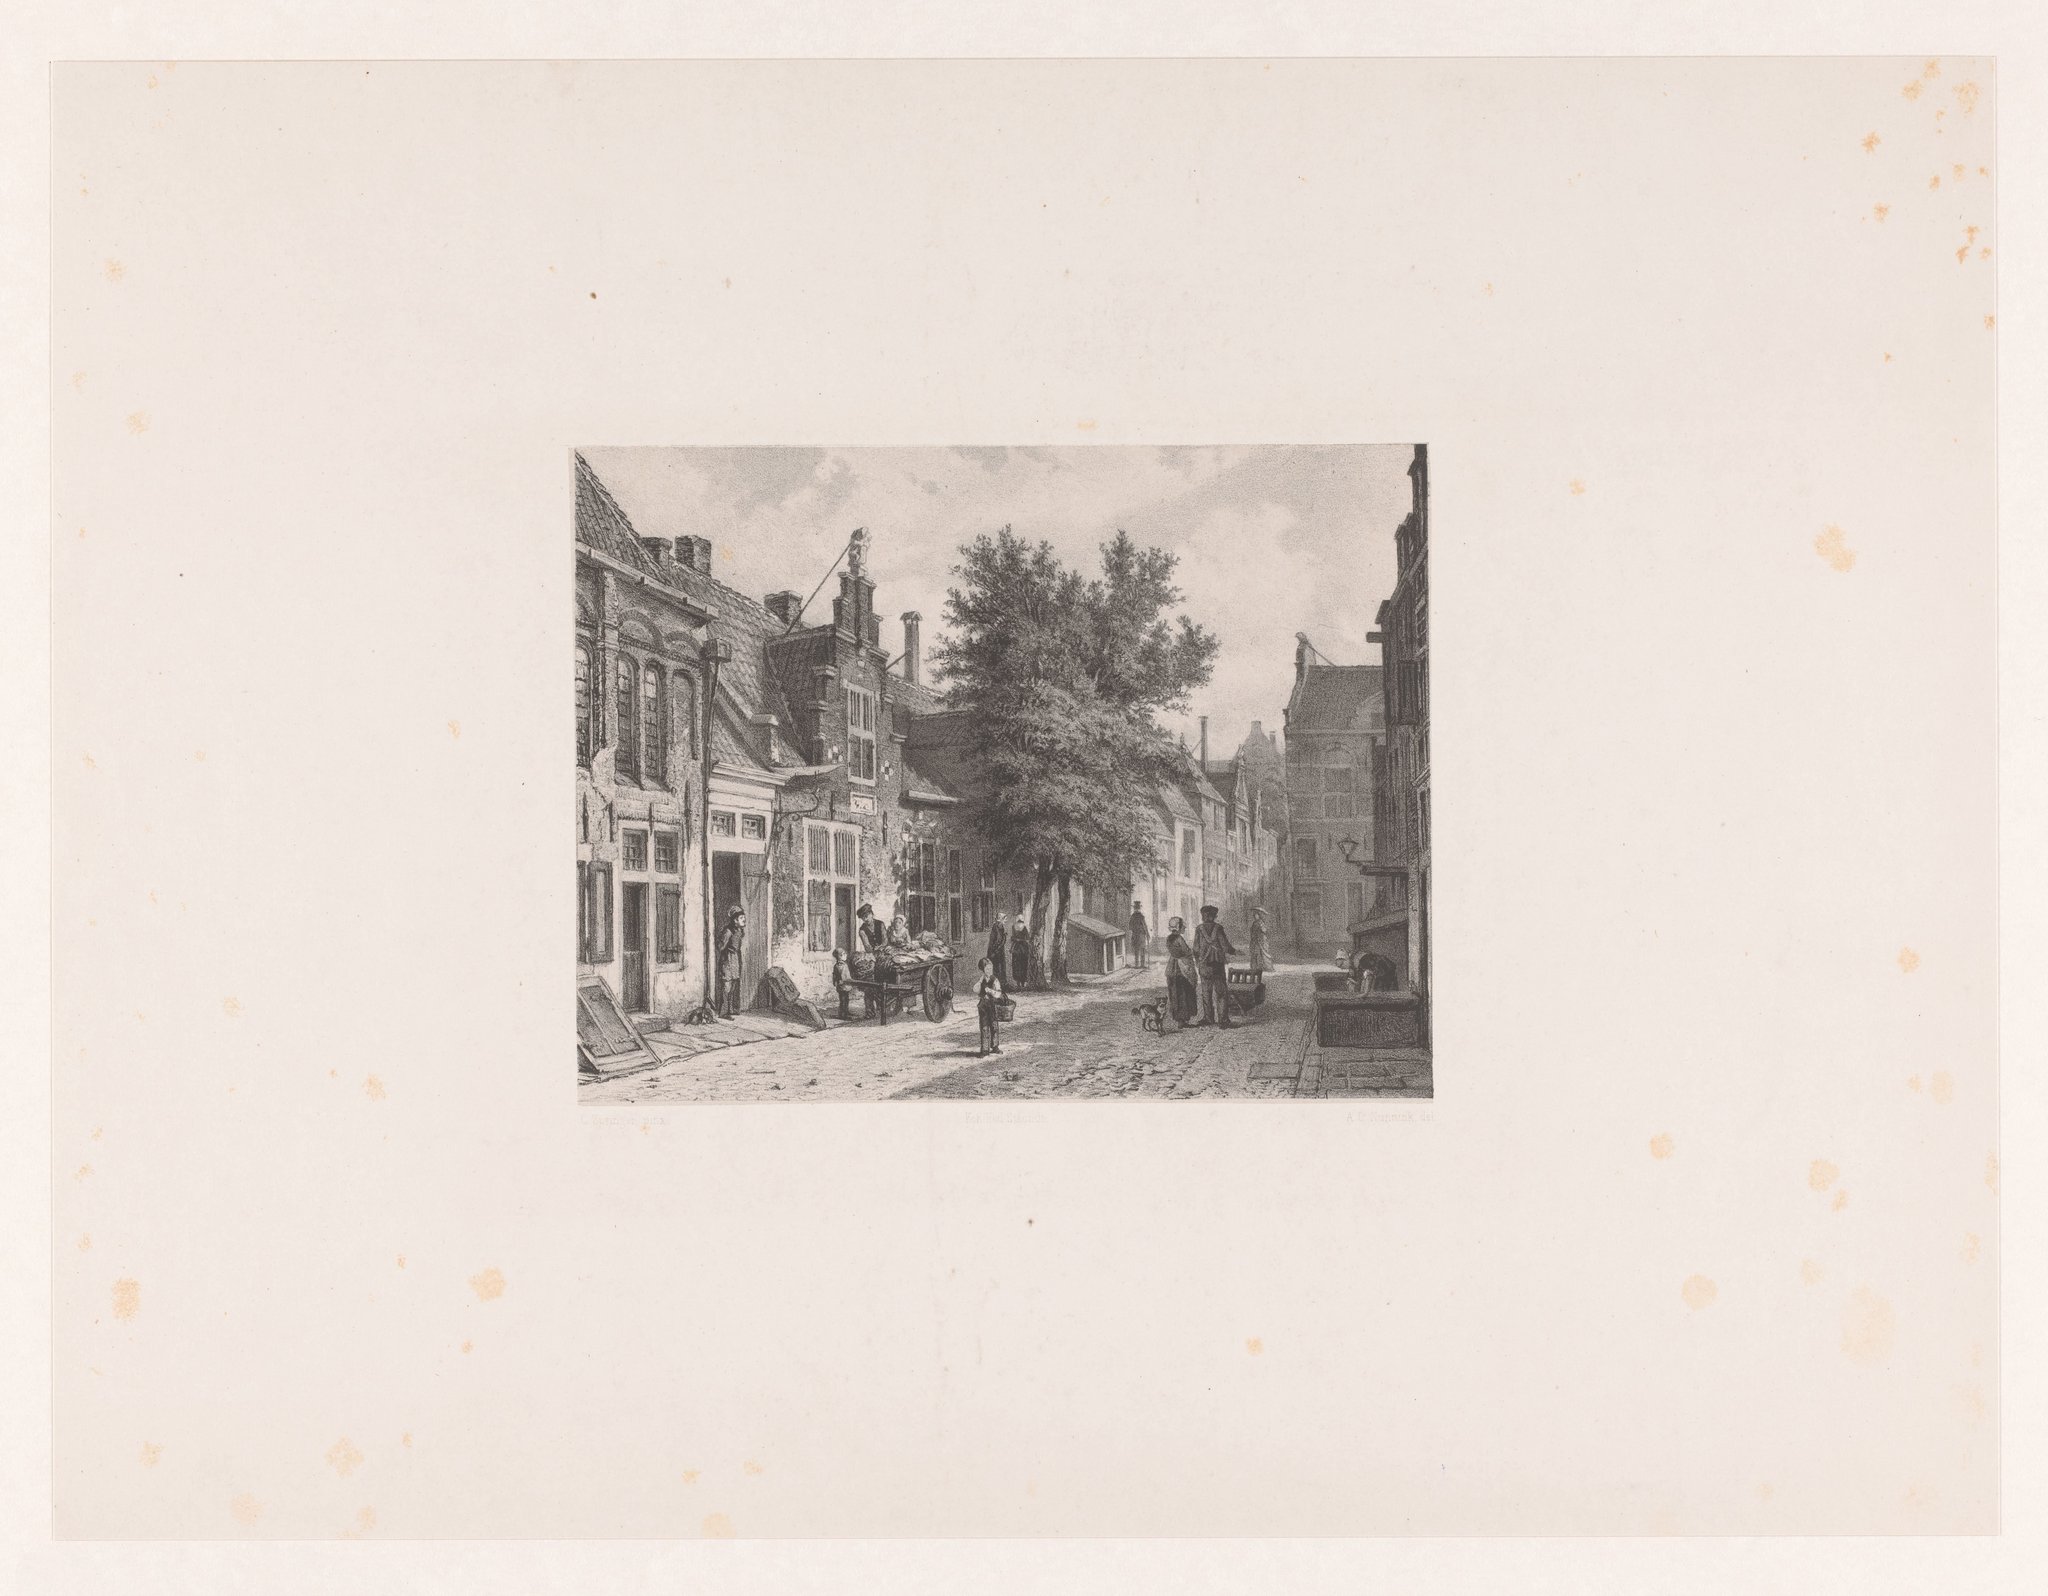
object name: print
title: Dorpsstraat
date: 1867-1874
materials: paper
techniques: lithograph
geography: the hague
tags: village street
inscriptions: collector's mark: Lugt 2228